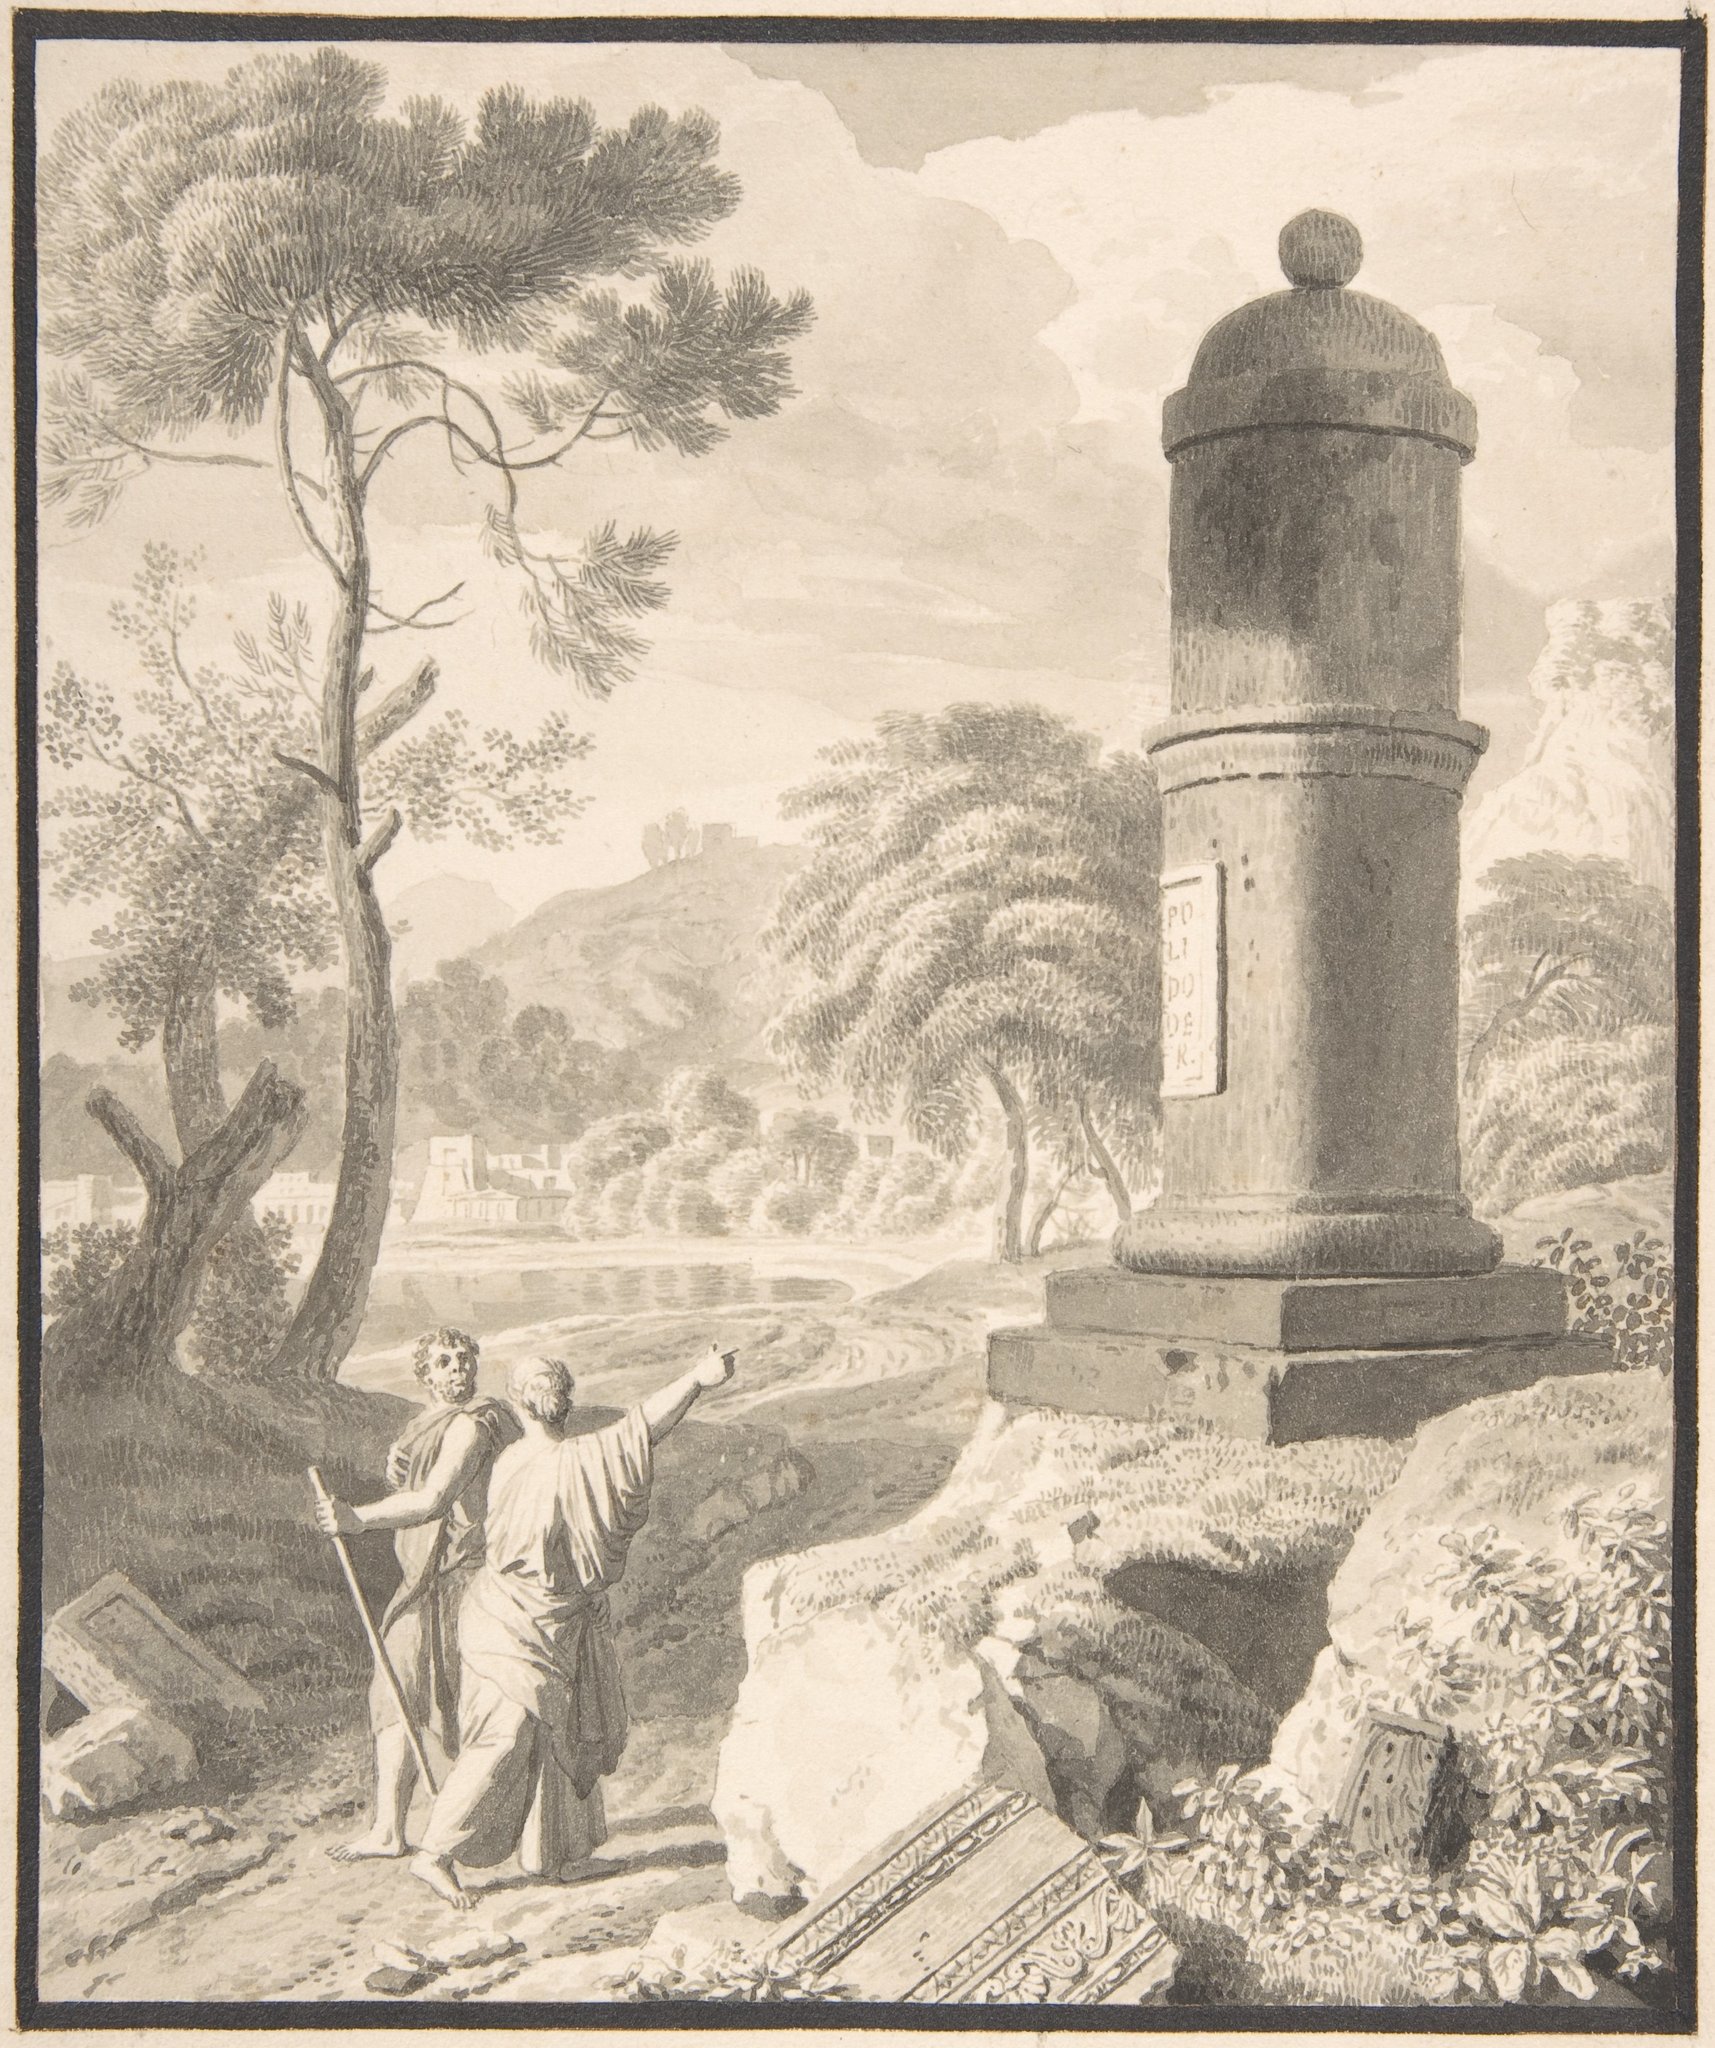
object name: drawing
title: Arcadian Landscape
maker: johannes glauber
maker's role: draughtsman, painter, print maker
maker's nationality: dutch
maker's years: 1646-1726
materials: ink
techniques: brush, wash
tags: monuments,men,landscapes